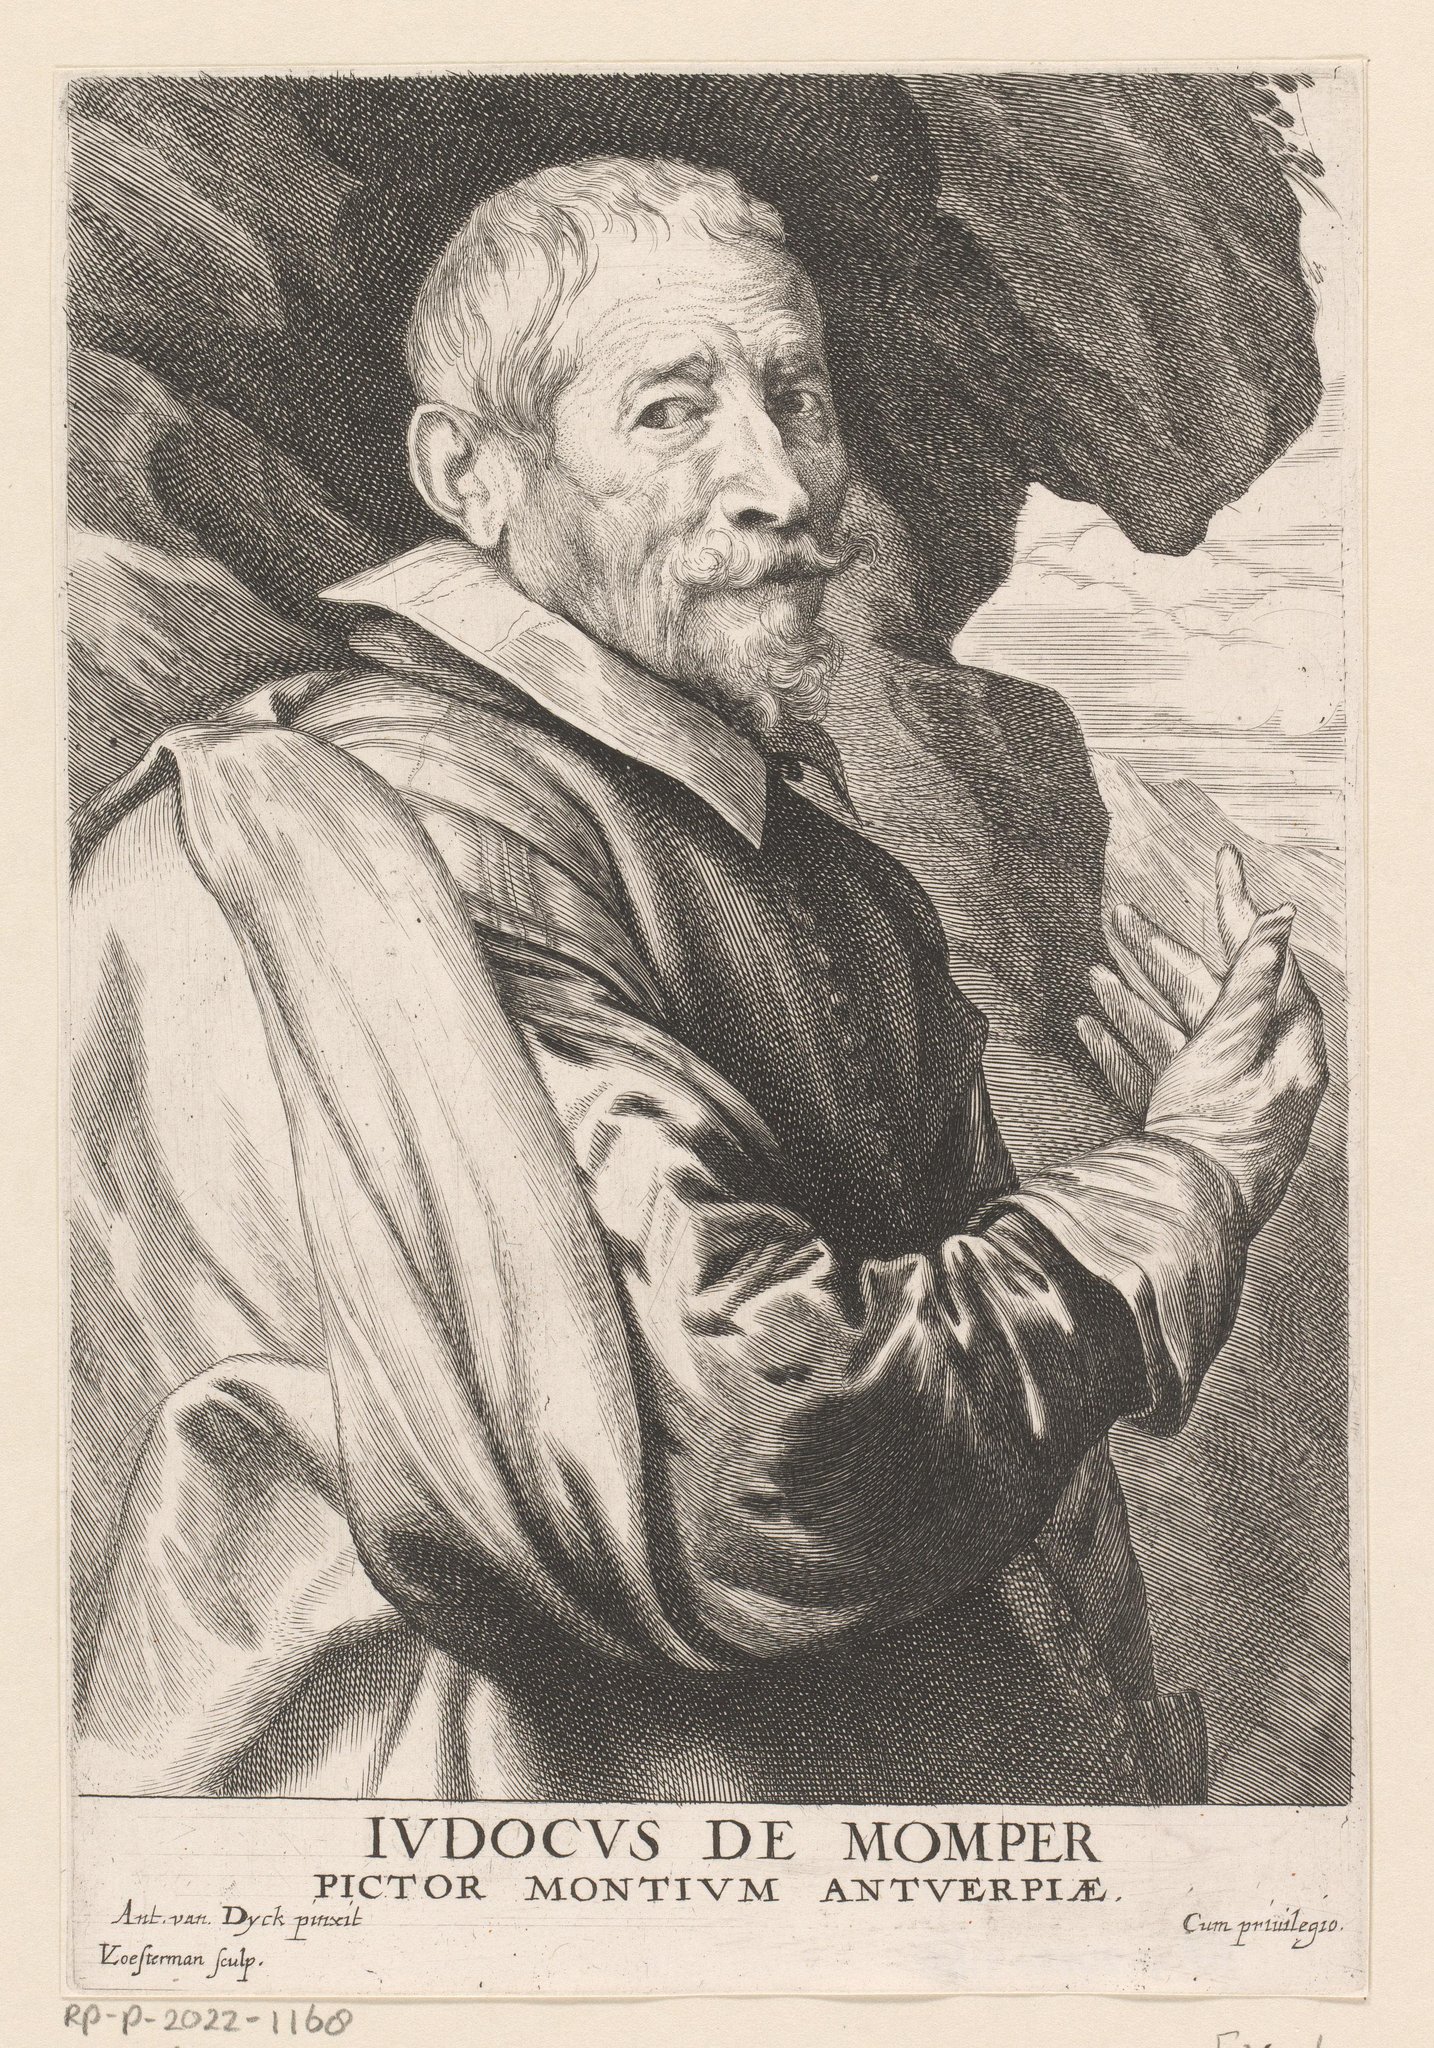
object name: book illustration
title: Iconographie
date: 1645-1646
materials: paper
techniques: engraving, etching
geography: antwerp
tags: painter, draughtsman, joos de momper (ii), historical persons, portrait, self-portrait of painter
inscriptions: collector's mark: Lugt 240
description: Prent gebruikt voor: Icones principum, virorum doctorum, pictorum, chalcographorum, statuariorum nec non amatorum pictoriae artis numero centum ab Ant. van Dyck ad vivum expressae ejusque sumptibus aeri incisae. Antwerpen: Gillis Hendricx, [1645-1646].